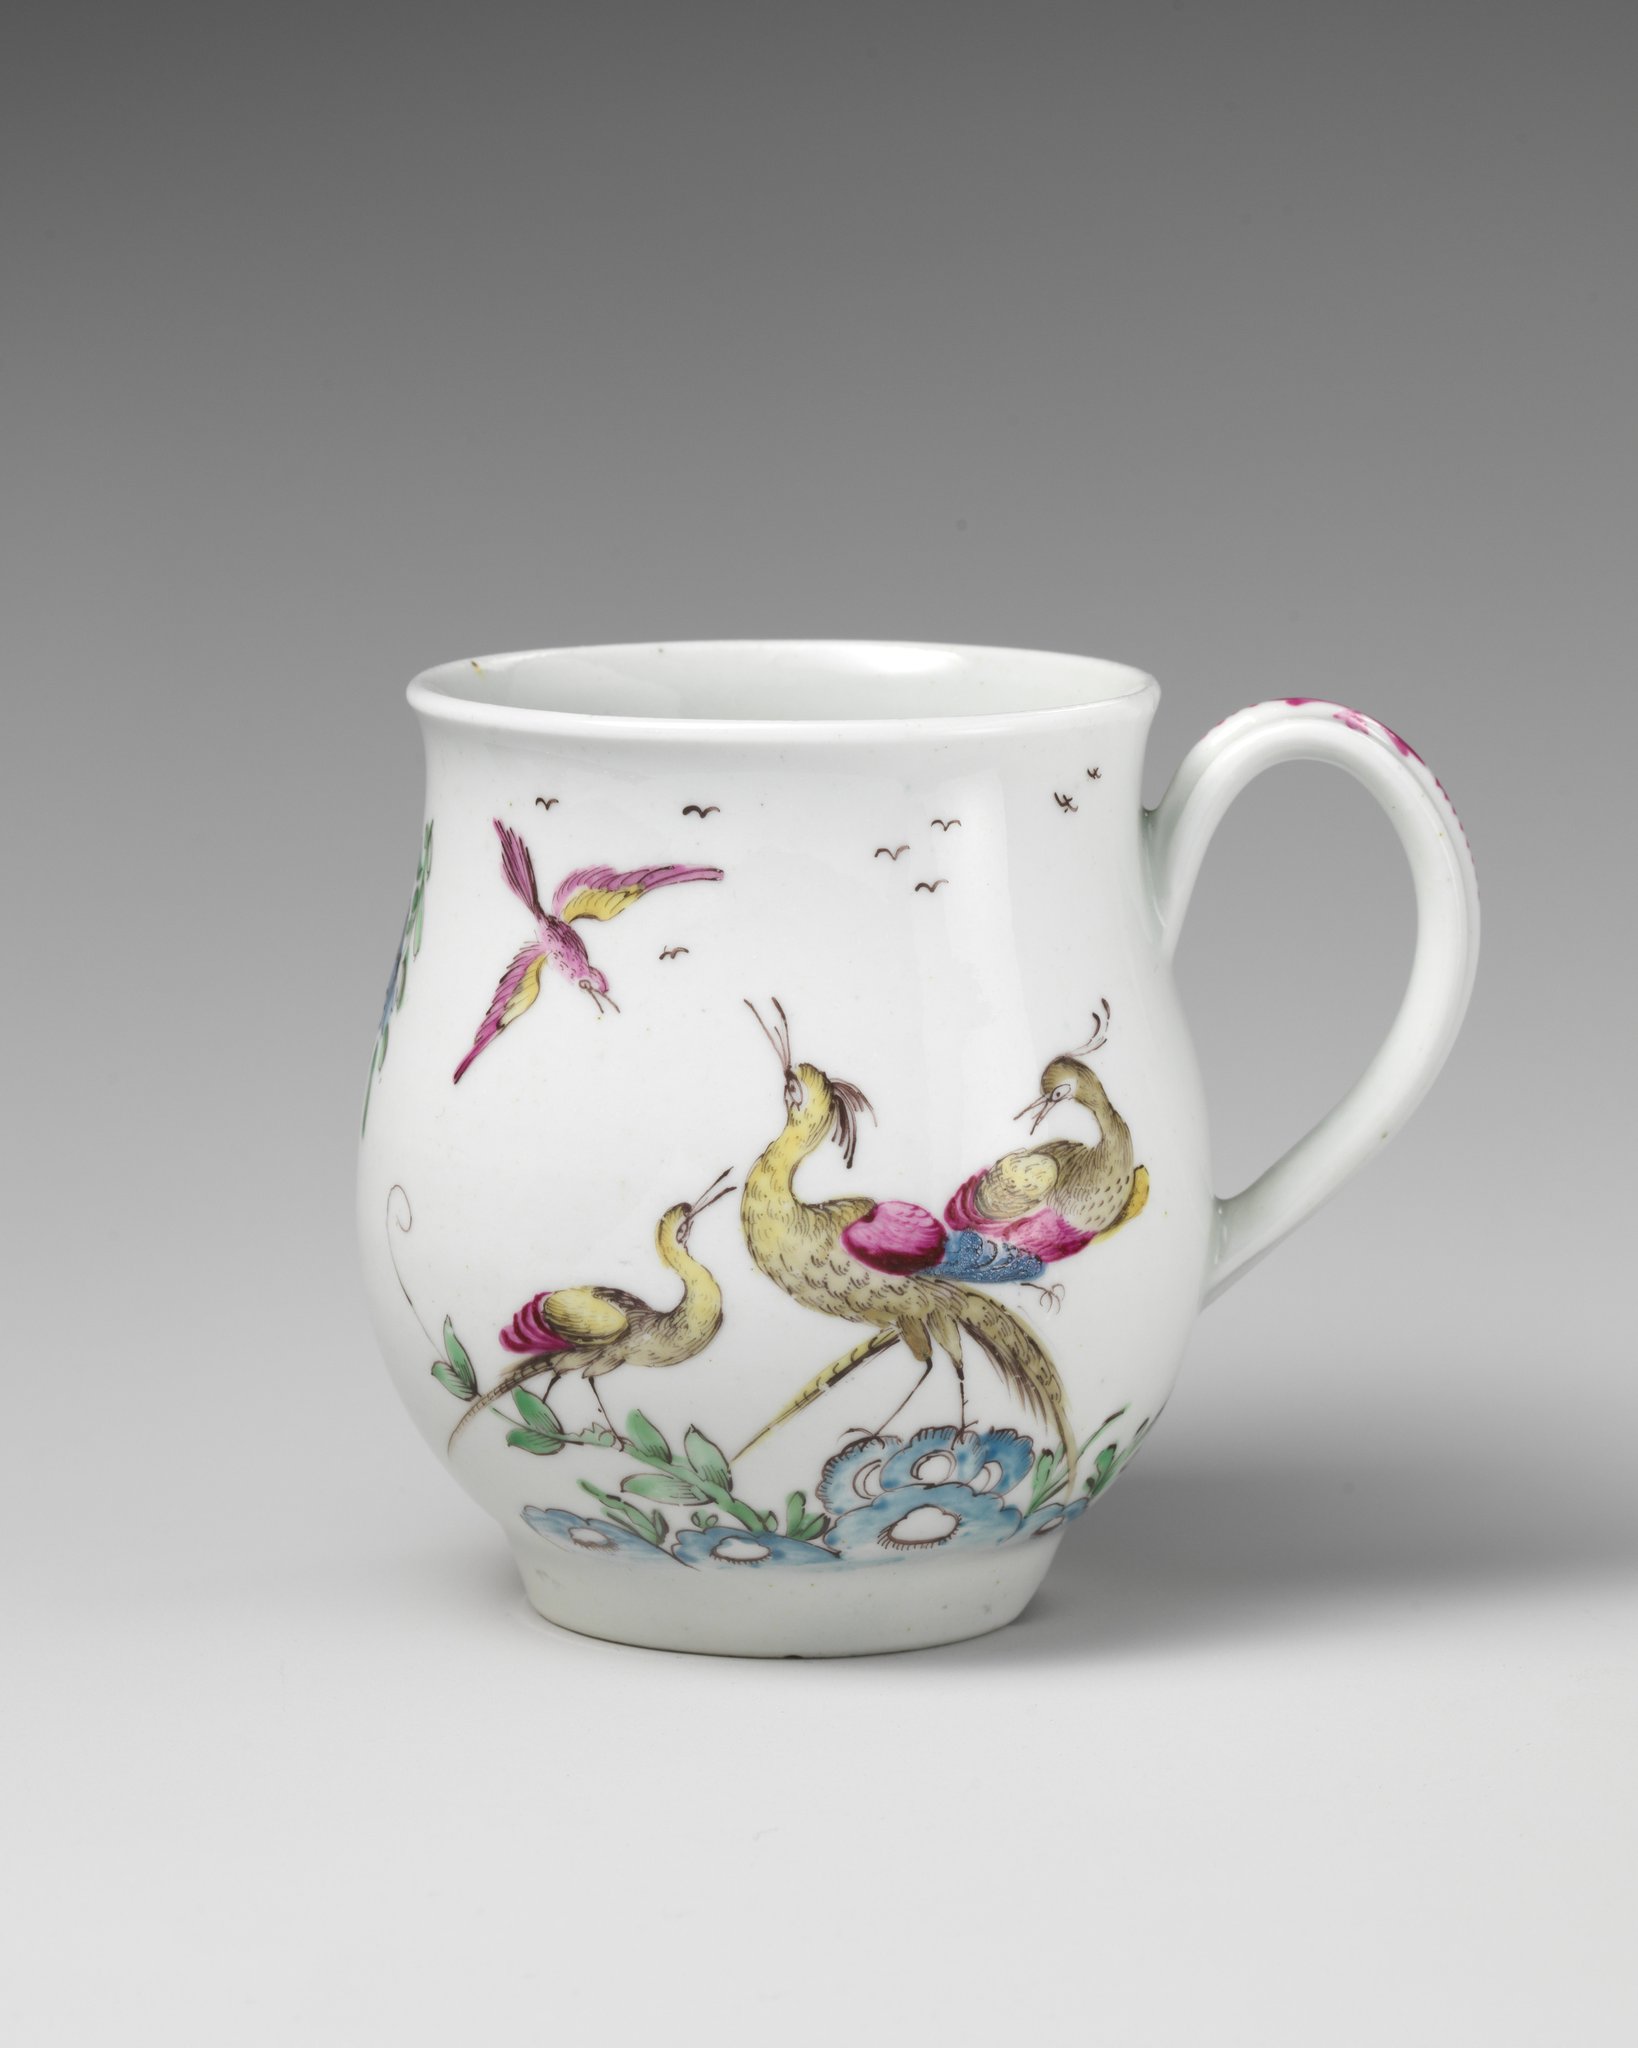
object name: tankard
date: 1701-1800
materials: soft paste porcelain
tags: birds